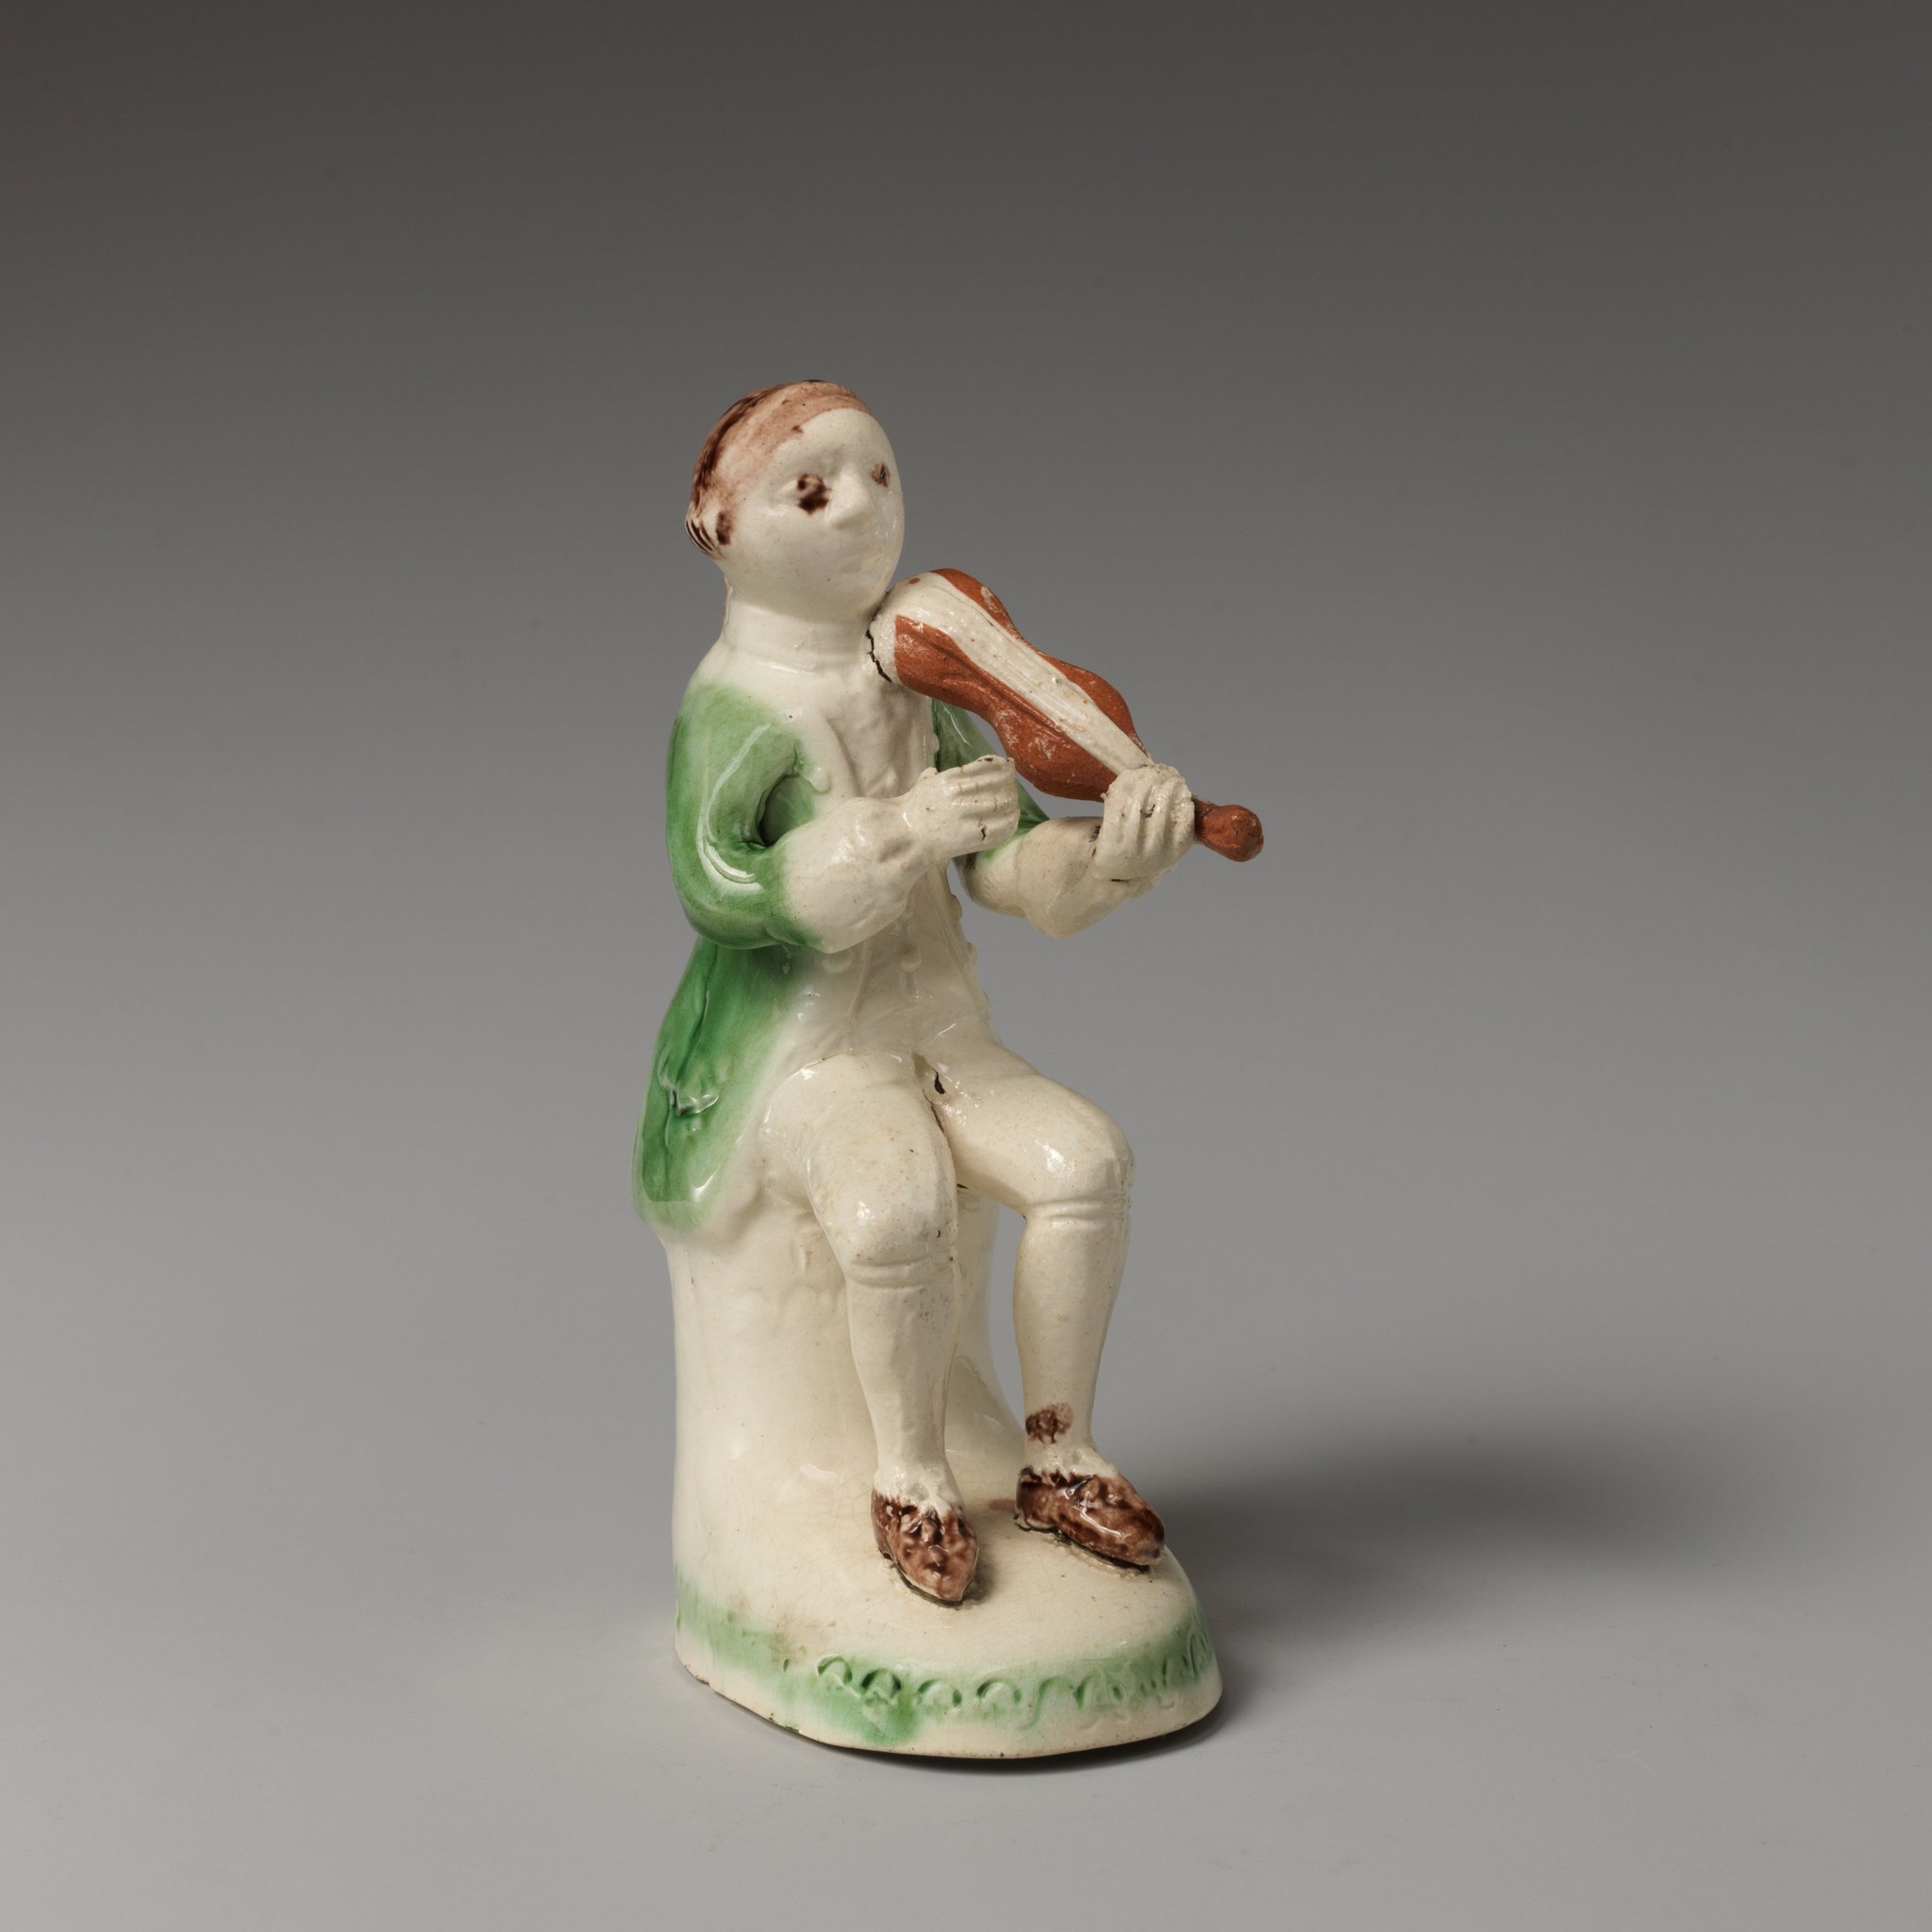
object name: figure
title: Fiddler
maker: astbury-whieldon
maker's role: maker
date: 1750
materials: earthenware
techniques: glazing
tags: men,violins